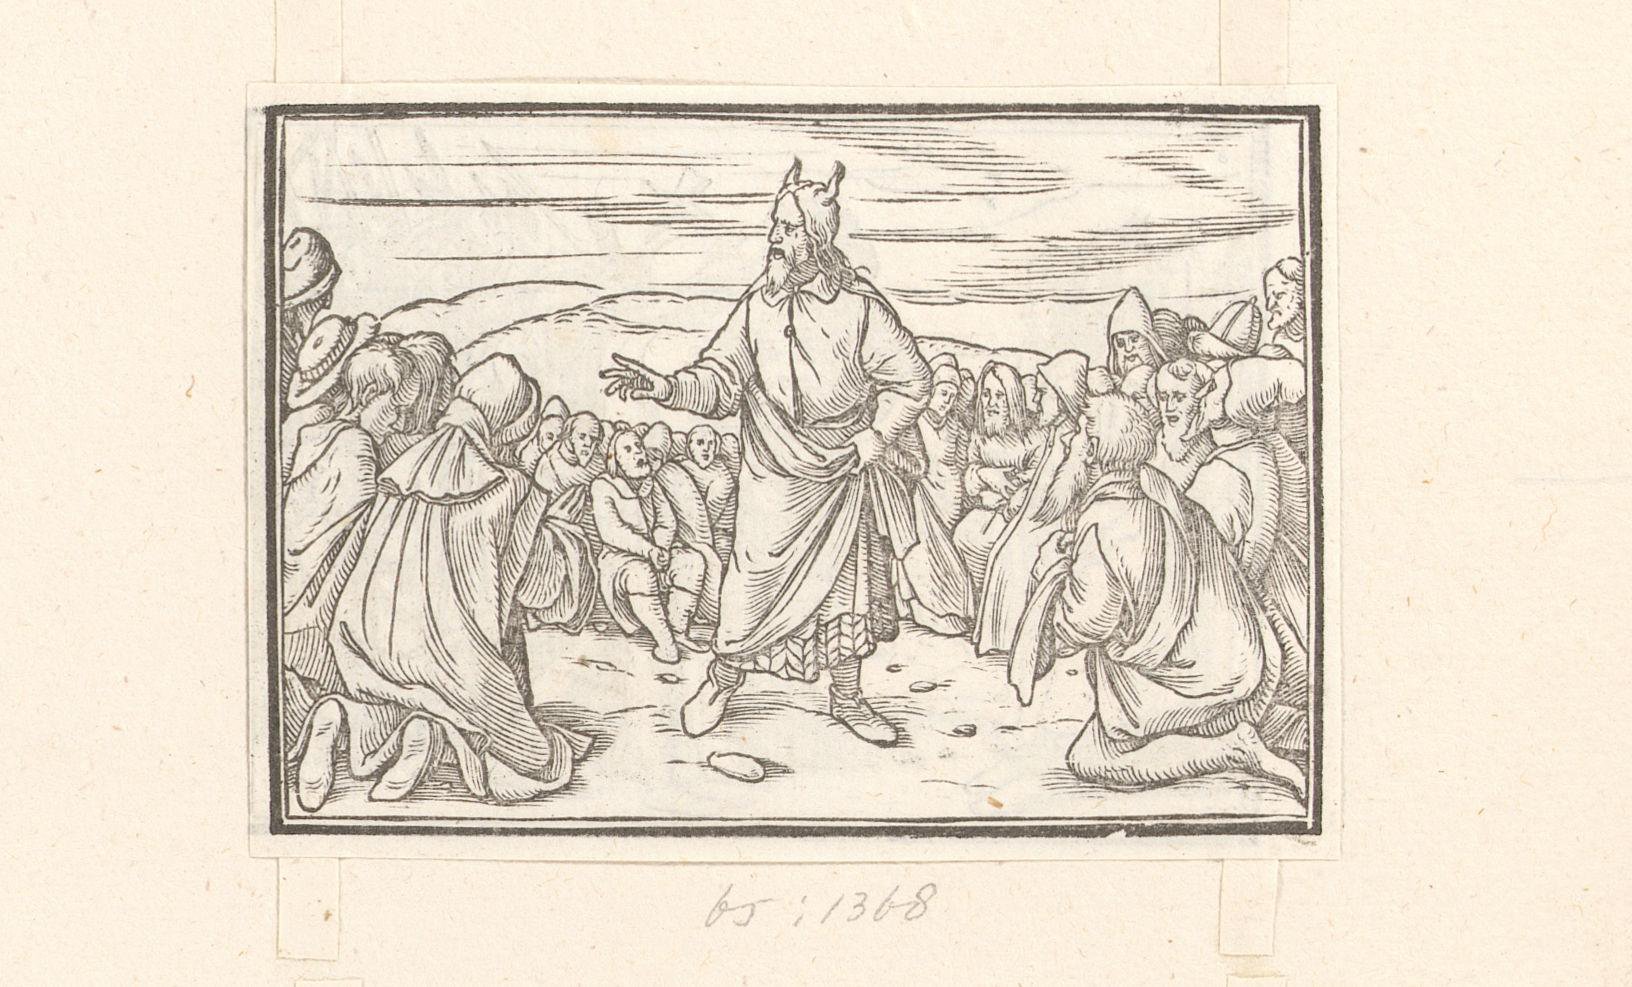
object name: album leaf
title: Geschiedenis van het Oude Testament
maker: veit rudolf specklin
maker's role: print maker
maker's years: -1550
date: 1538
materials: paper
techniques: woodcut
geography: switzerland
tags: moses teaching (in general)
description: Boekillustratie voor het eerst gebruikt in: Biblia Utriusque Testamenti iuxta Vulgatam Translationem, Lyon, M. en G. Trechsel (voor Hugo à Porta) 1538. Later in verschillende uitgaven opnieuw gebruikt. Deze prent vermoedelijk gebruikt in één van de uitgaven uitgegeven en/of gedrukt door Jean Frellon, Lyon.